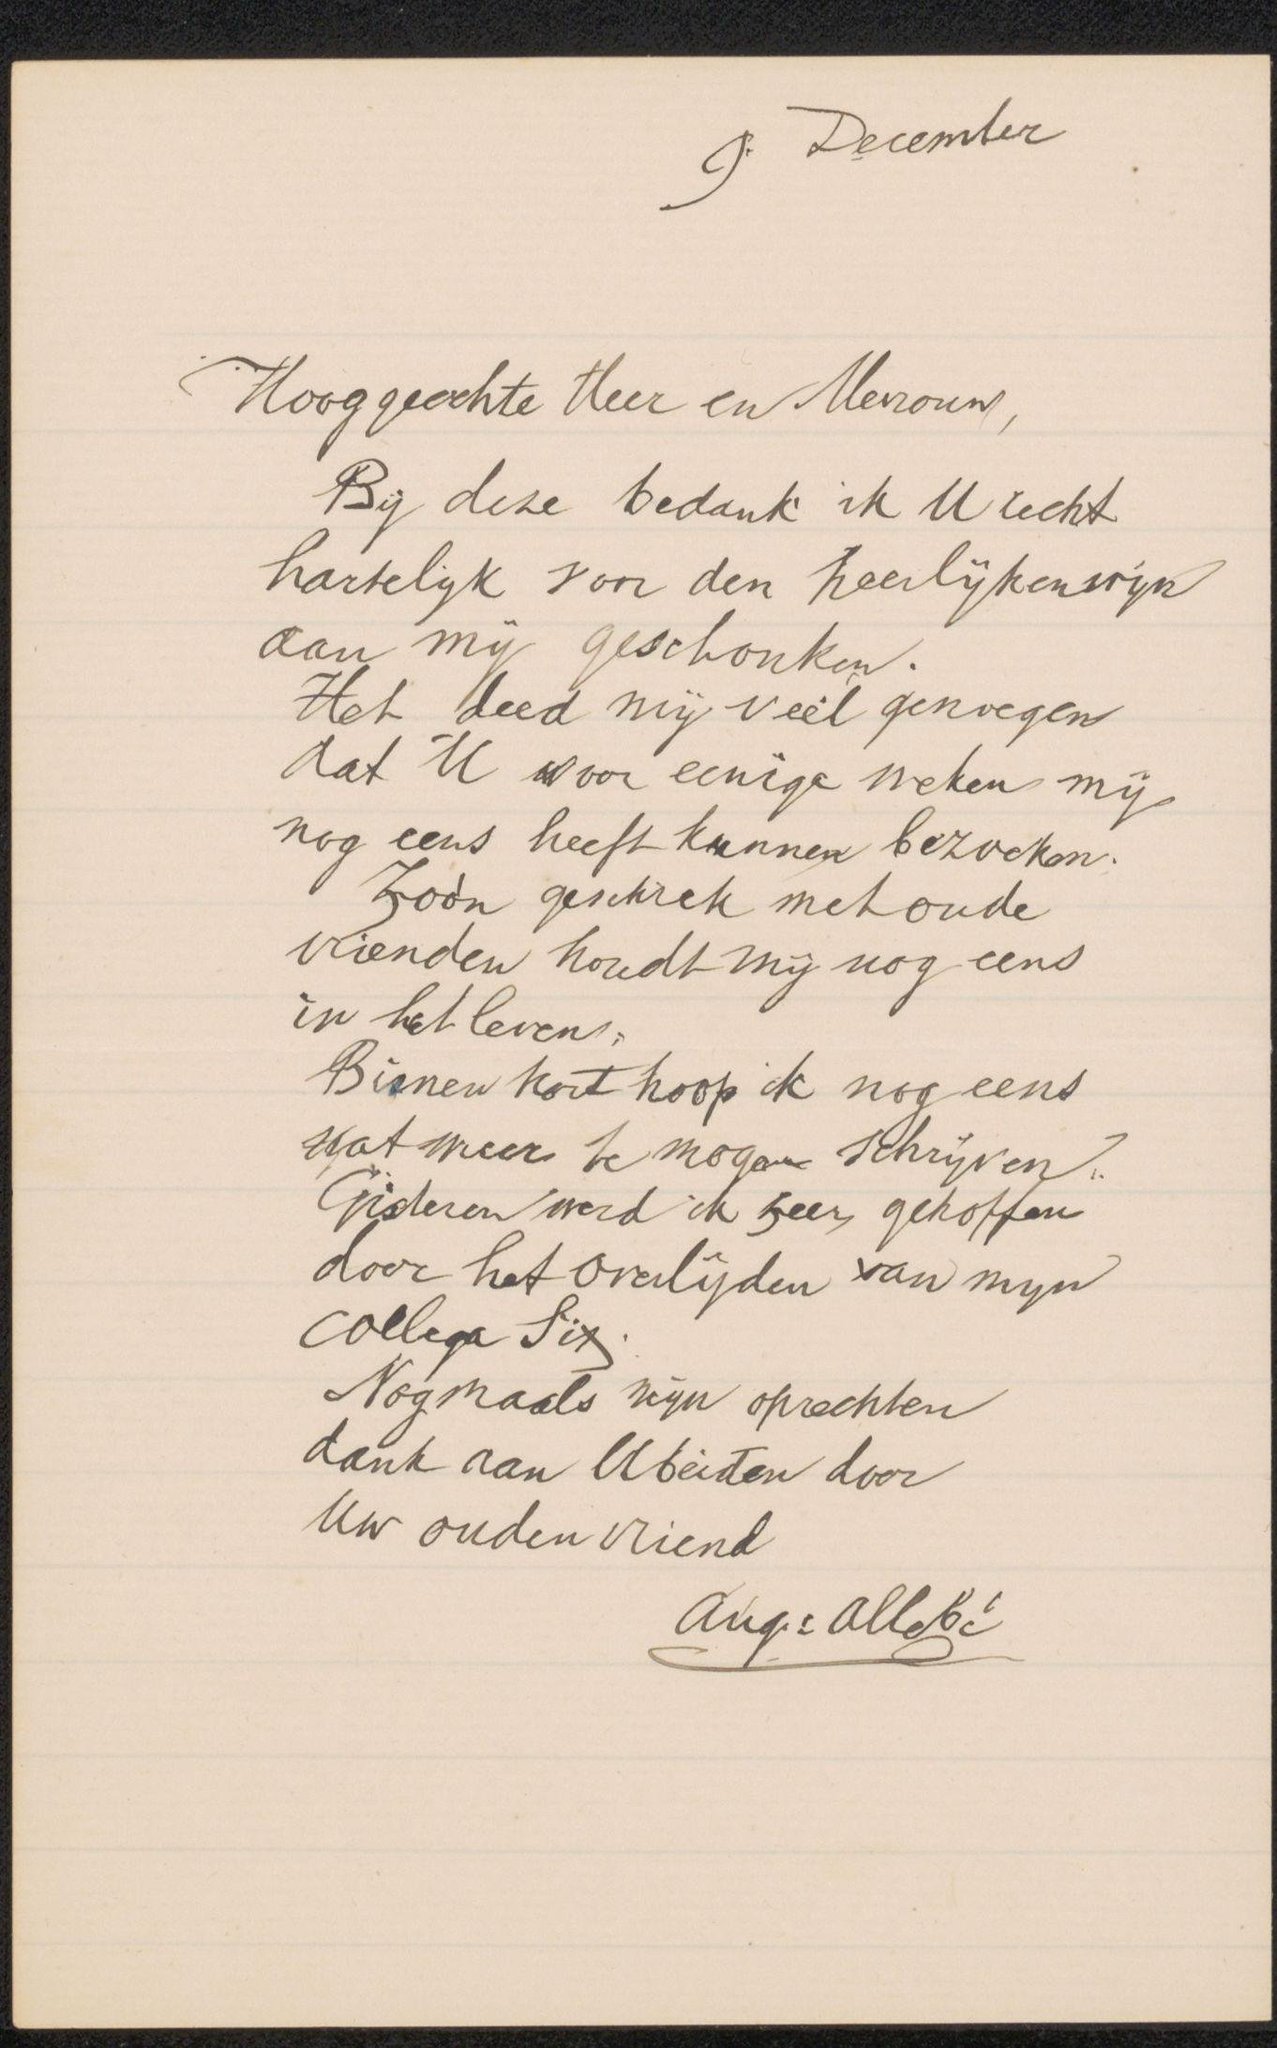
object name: letter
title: Brief aan Max Wilhelm Carl Weber en Anne Antoinette Weber-Van Bosse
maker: august allebé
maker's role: draughtsman, print maker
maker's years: 1838-1927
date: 1926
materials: ink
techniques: pen, writing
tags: anne antoinette weber-van bosse, jonkheer jan six